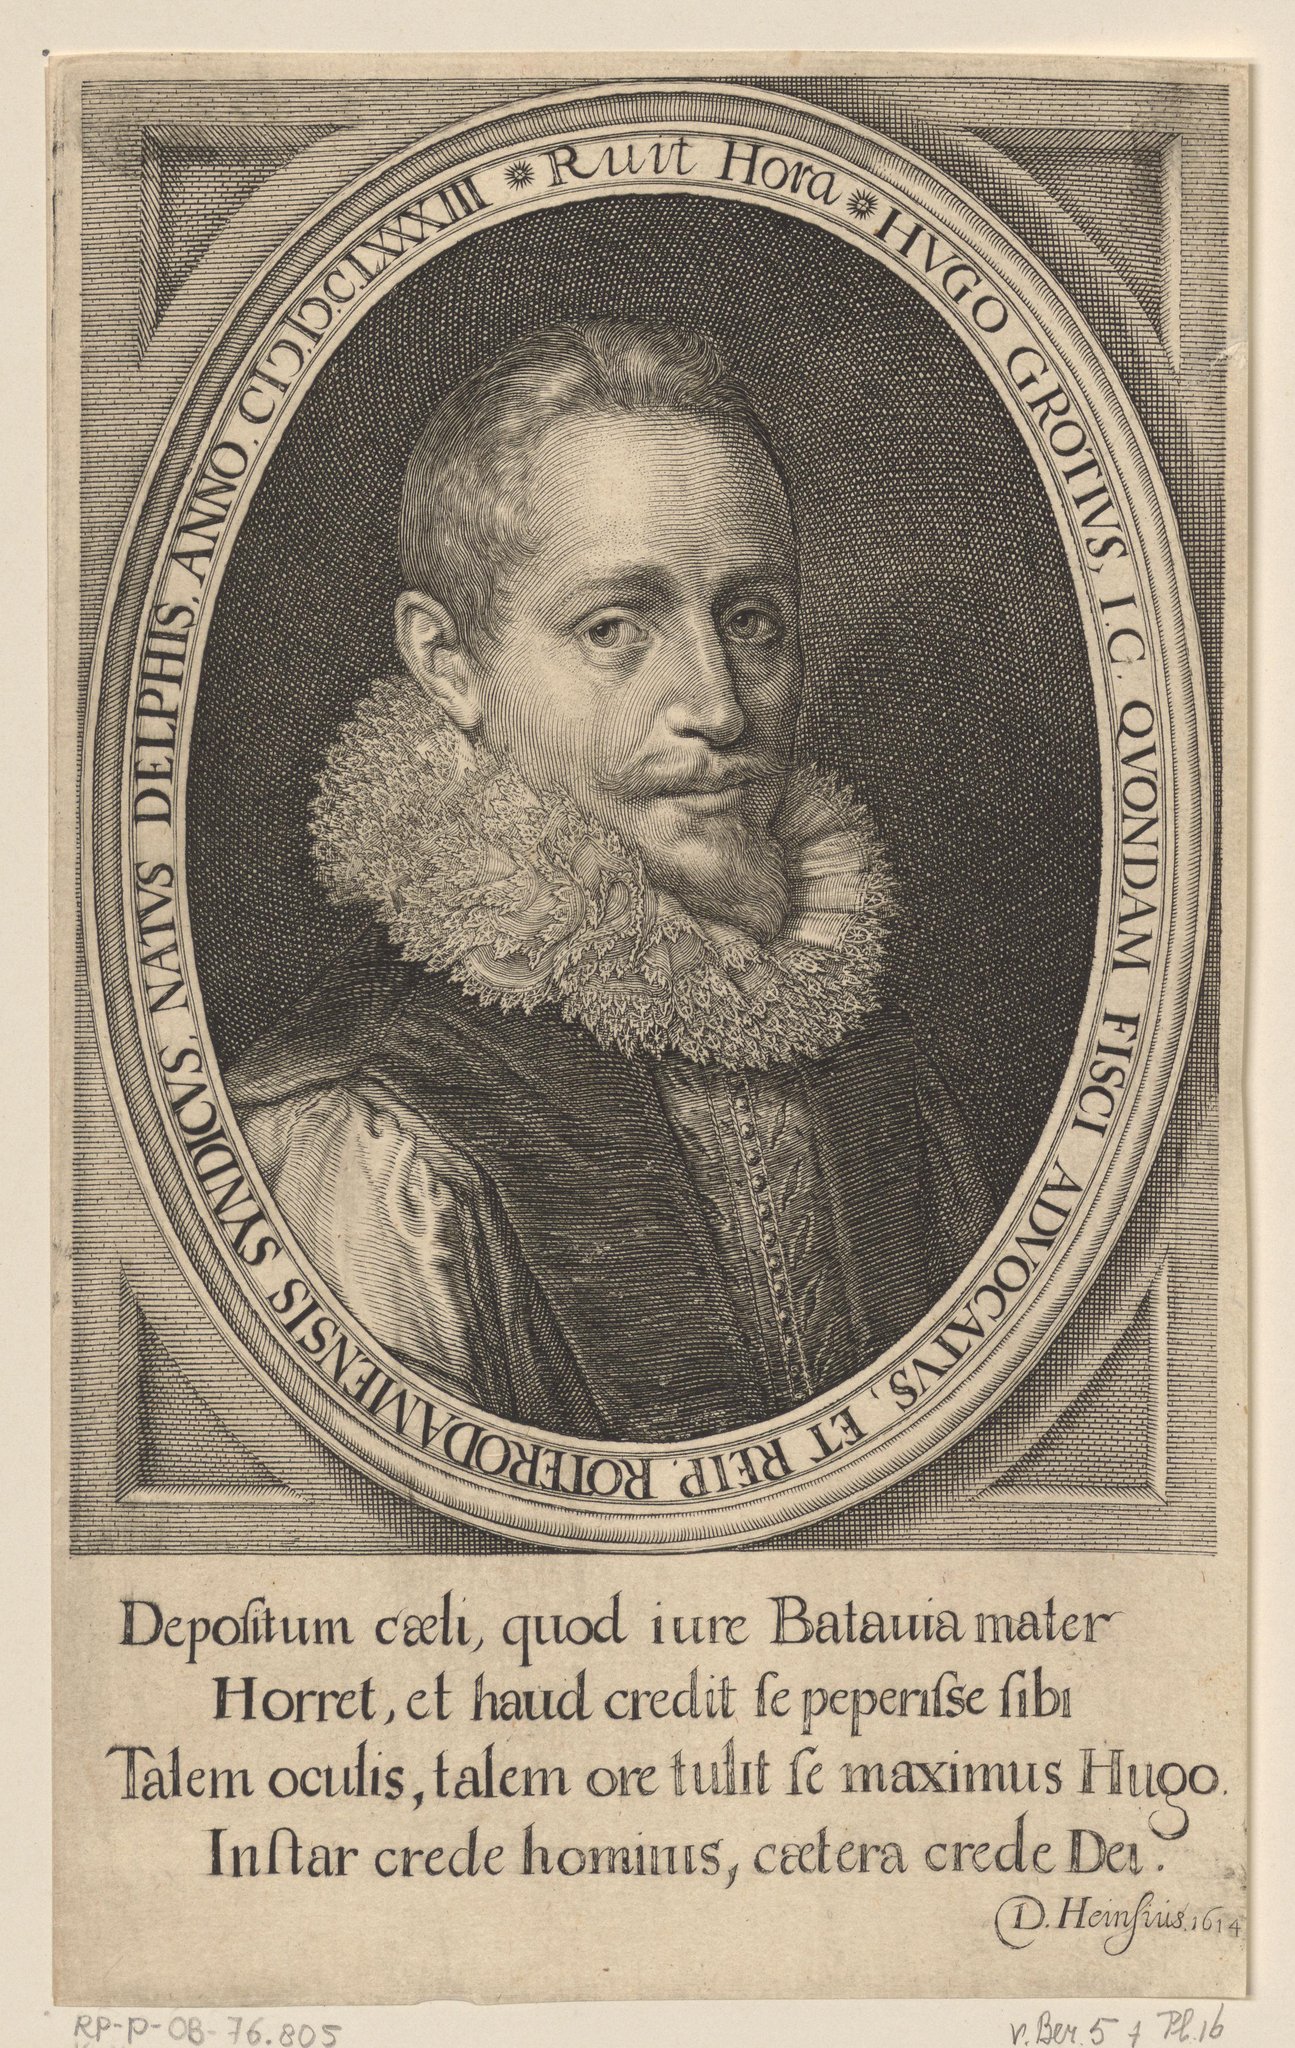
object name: print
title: Portret van Hugo de Groot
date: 1683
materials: paper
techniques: engraving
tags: delft, hugo de groot, historical persons, portrait of a writer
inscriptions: collector's mark: Lugt 240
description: Tekst in het Latijn in de ondermarge en in de omlijsting.